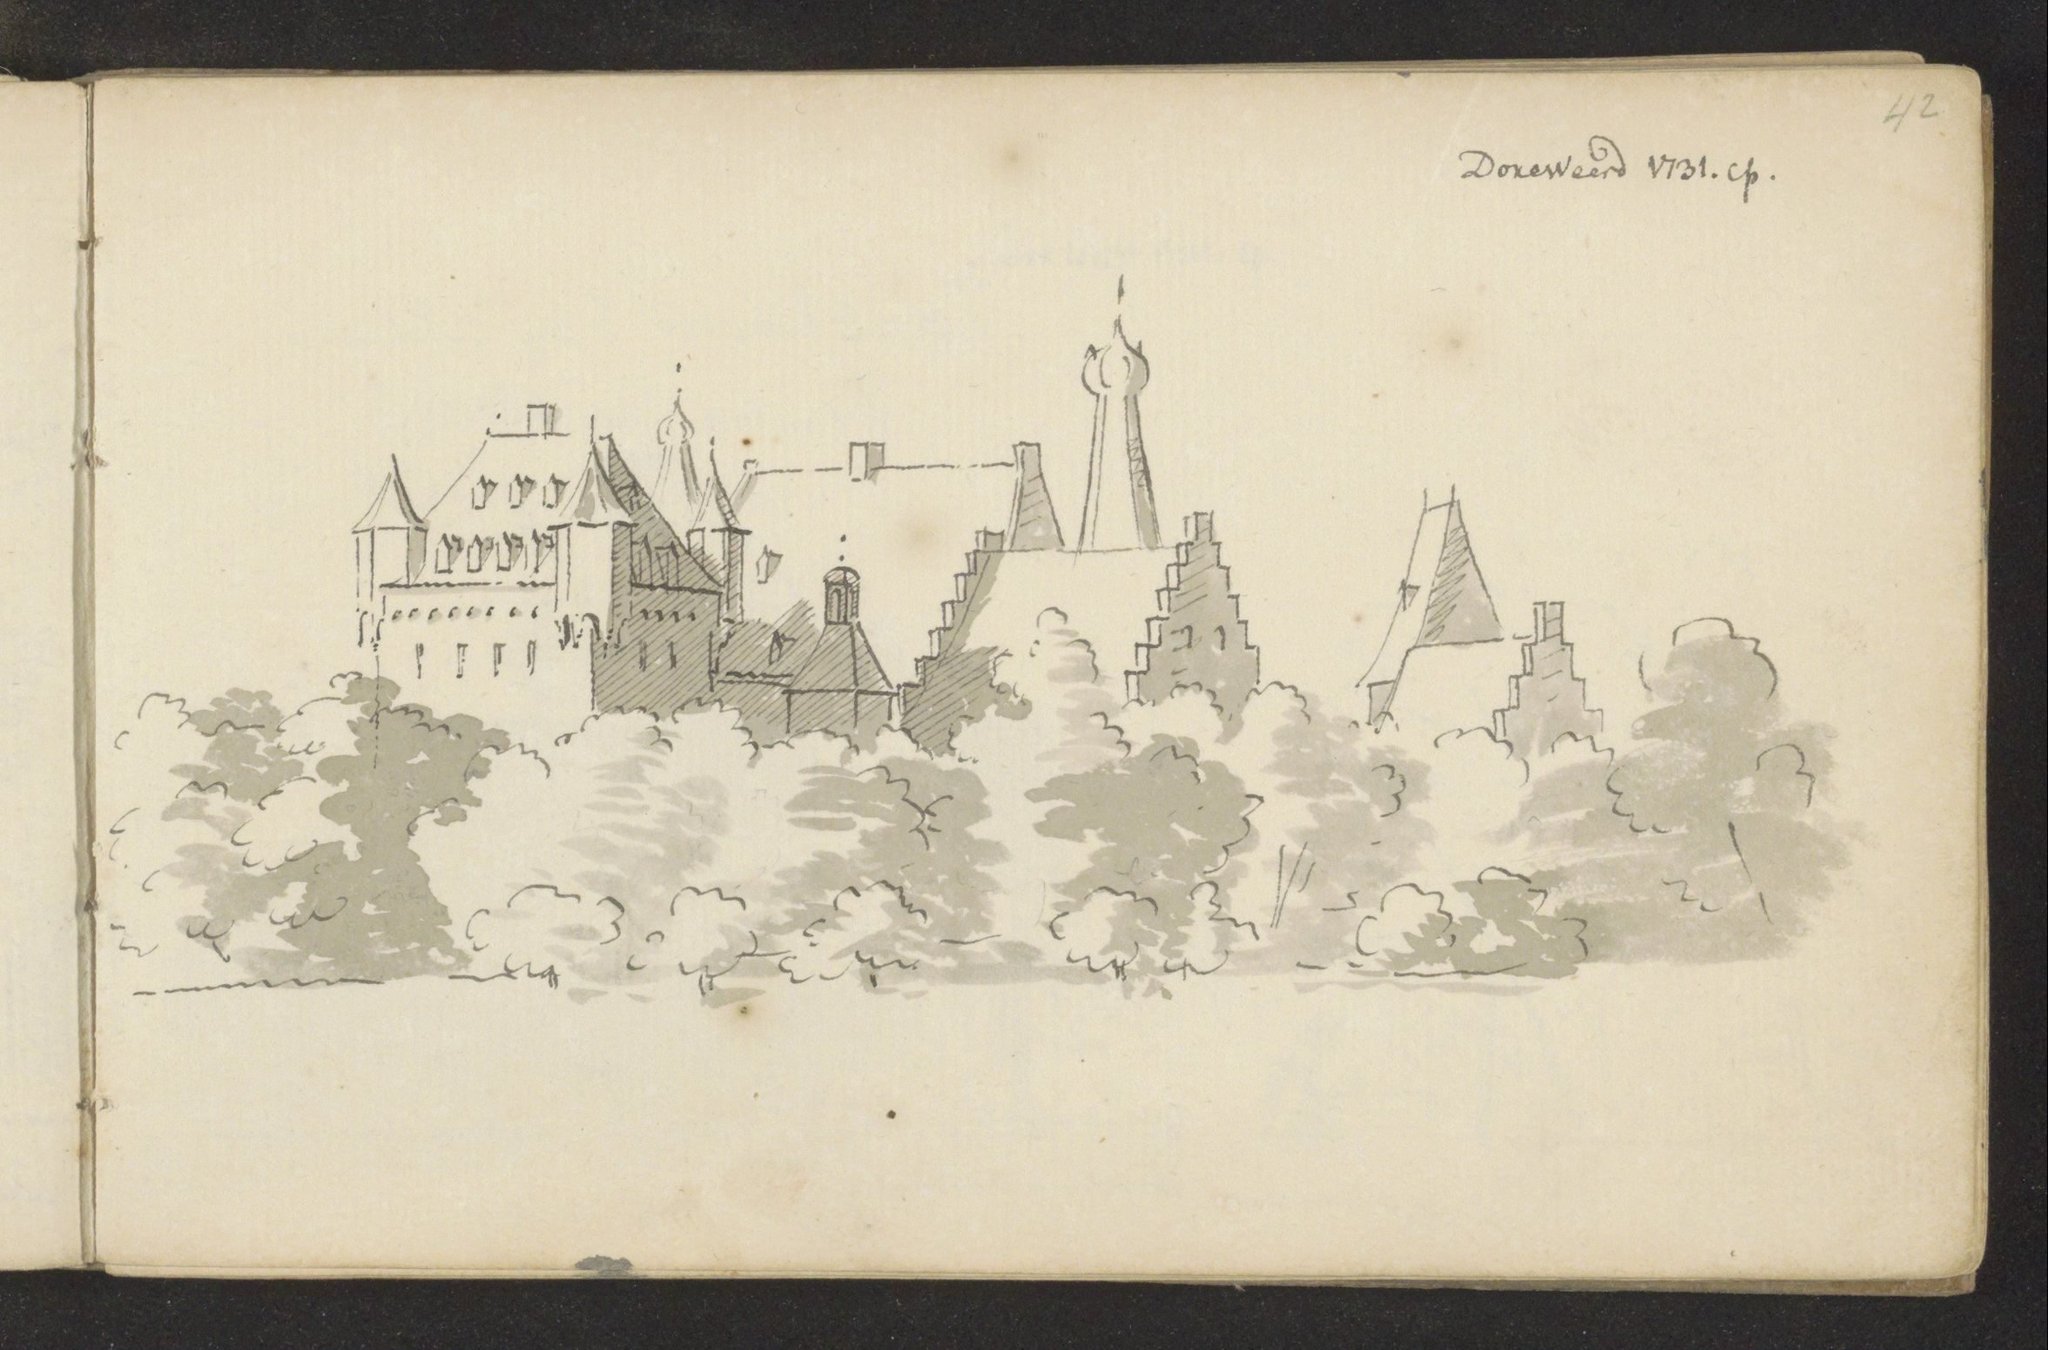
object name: sketchbook leaf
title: Gezicht op kasteel Doorwerth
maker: abraham de haen (ii)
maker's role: draughtsman, print maker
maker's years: 1707-1748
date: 1731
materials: ink, paper, pencil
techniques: brush, pen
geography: doorwerth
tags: landscape with tower or castle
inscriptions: date and inscription: ‘Doreweerd 1731.cp.’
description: Blad 42 recto uit een schetsboek met 78 bladen.